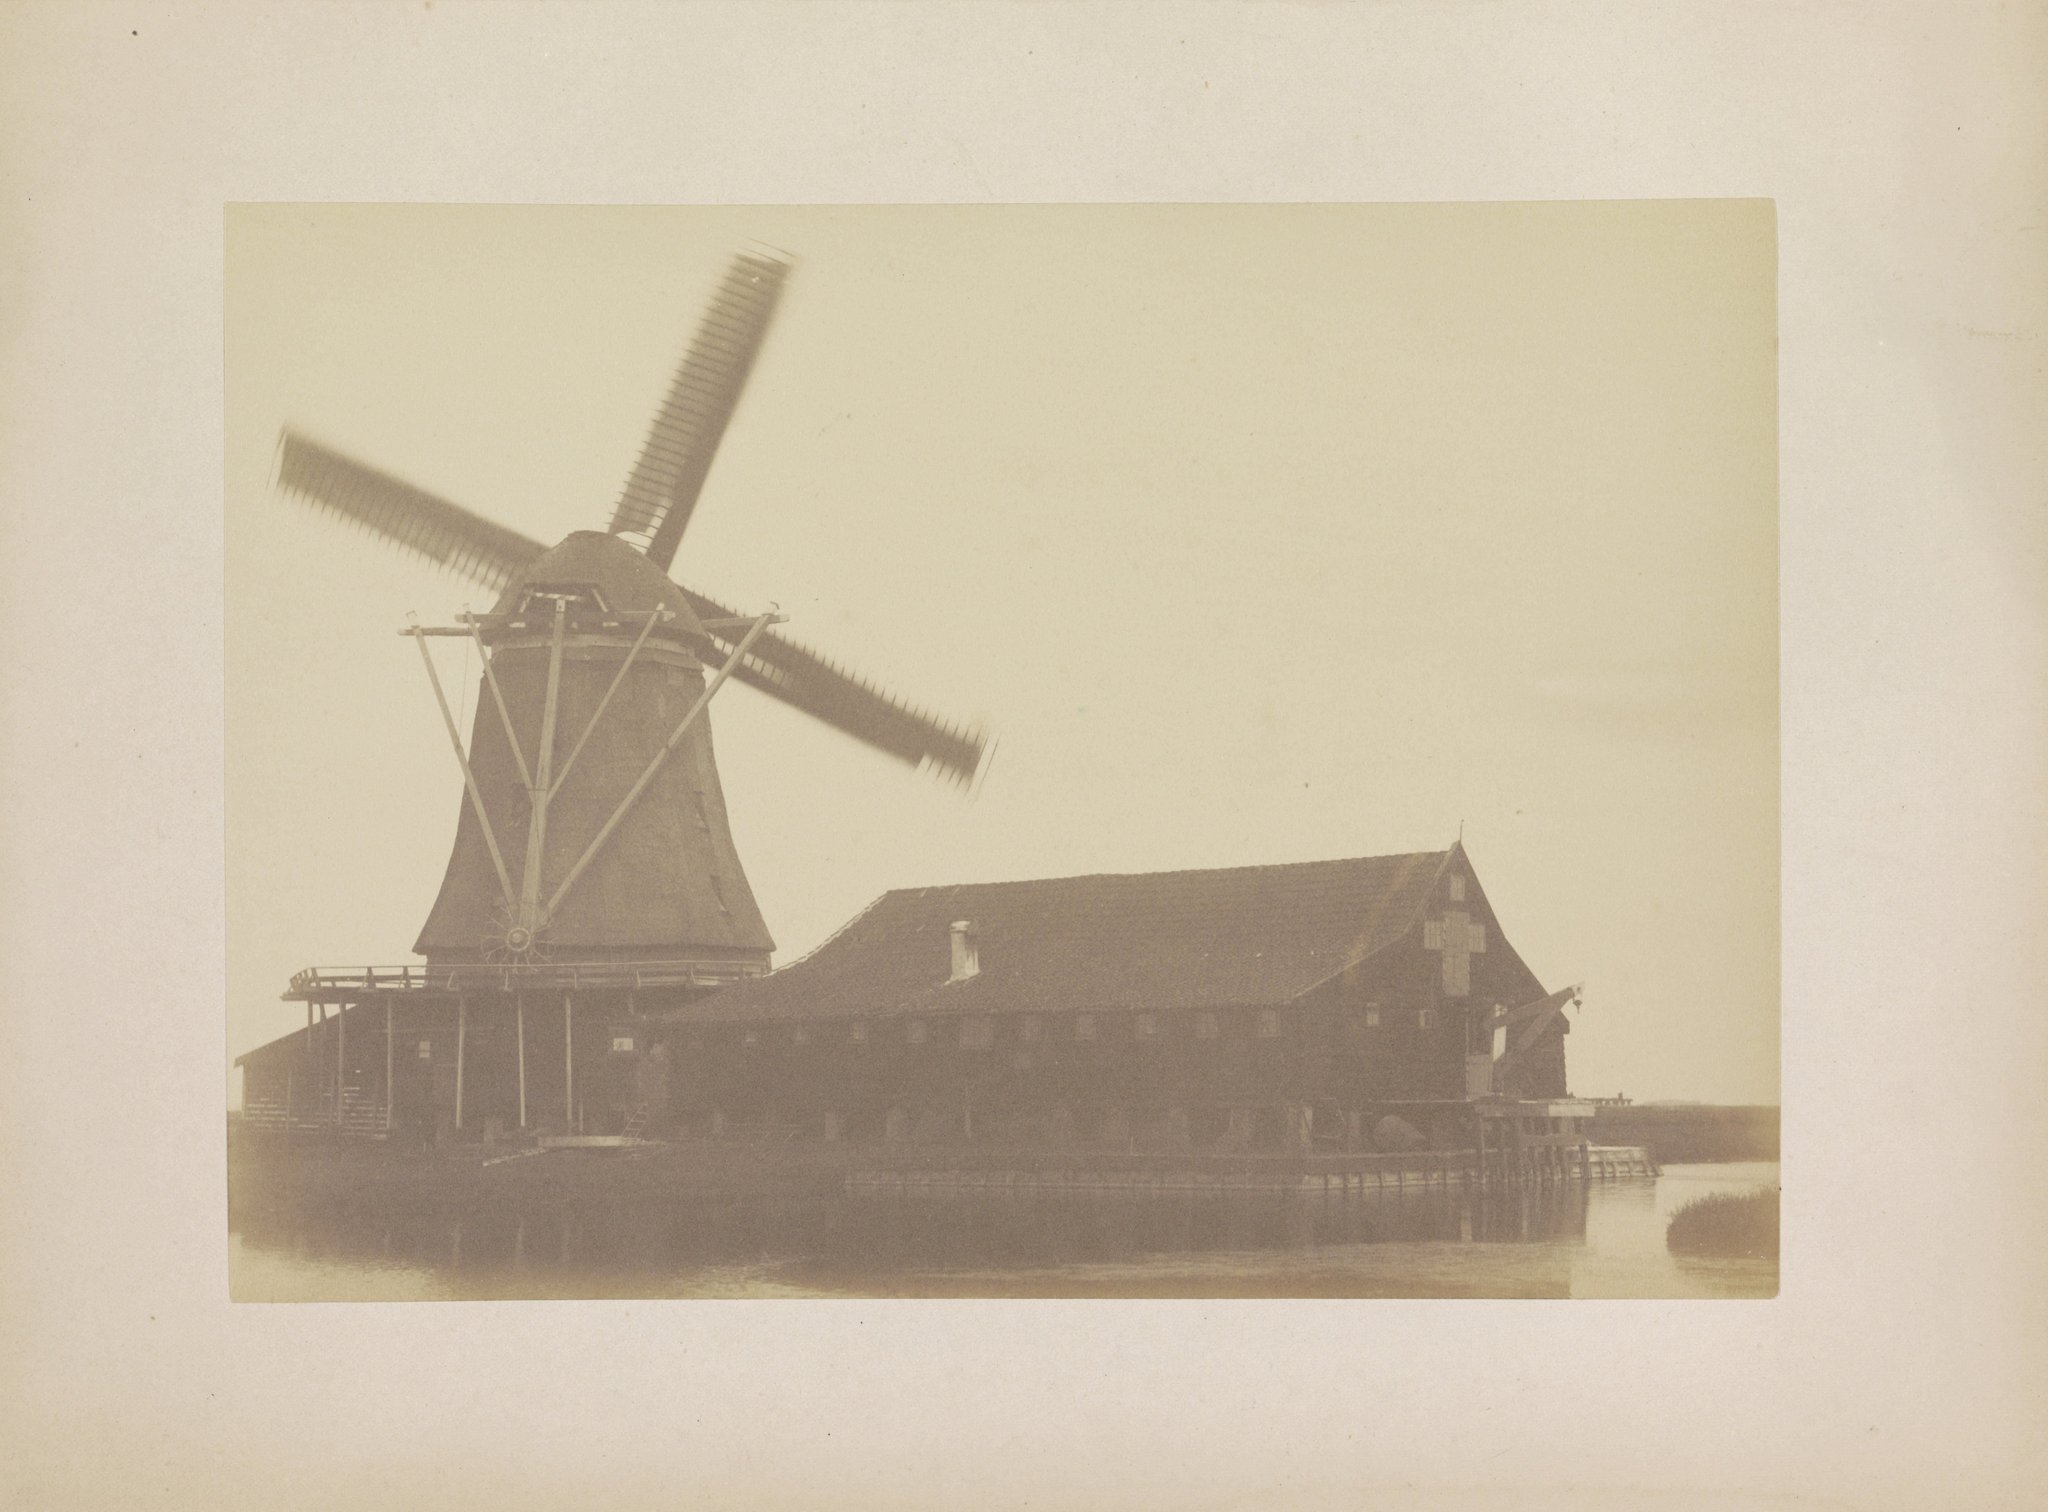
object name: photograph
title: Molen en een schuur aan het water in Zaandam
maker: Anonymous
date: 1885-1900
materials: paper, photographic support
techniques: albumen print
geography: france